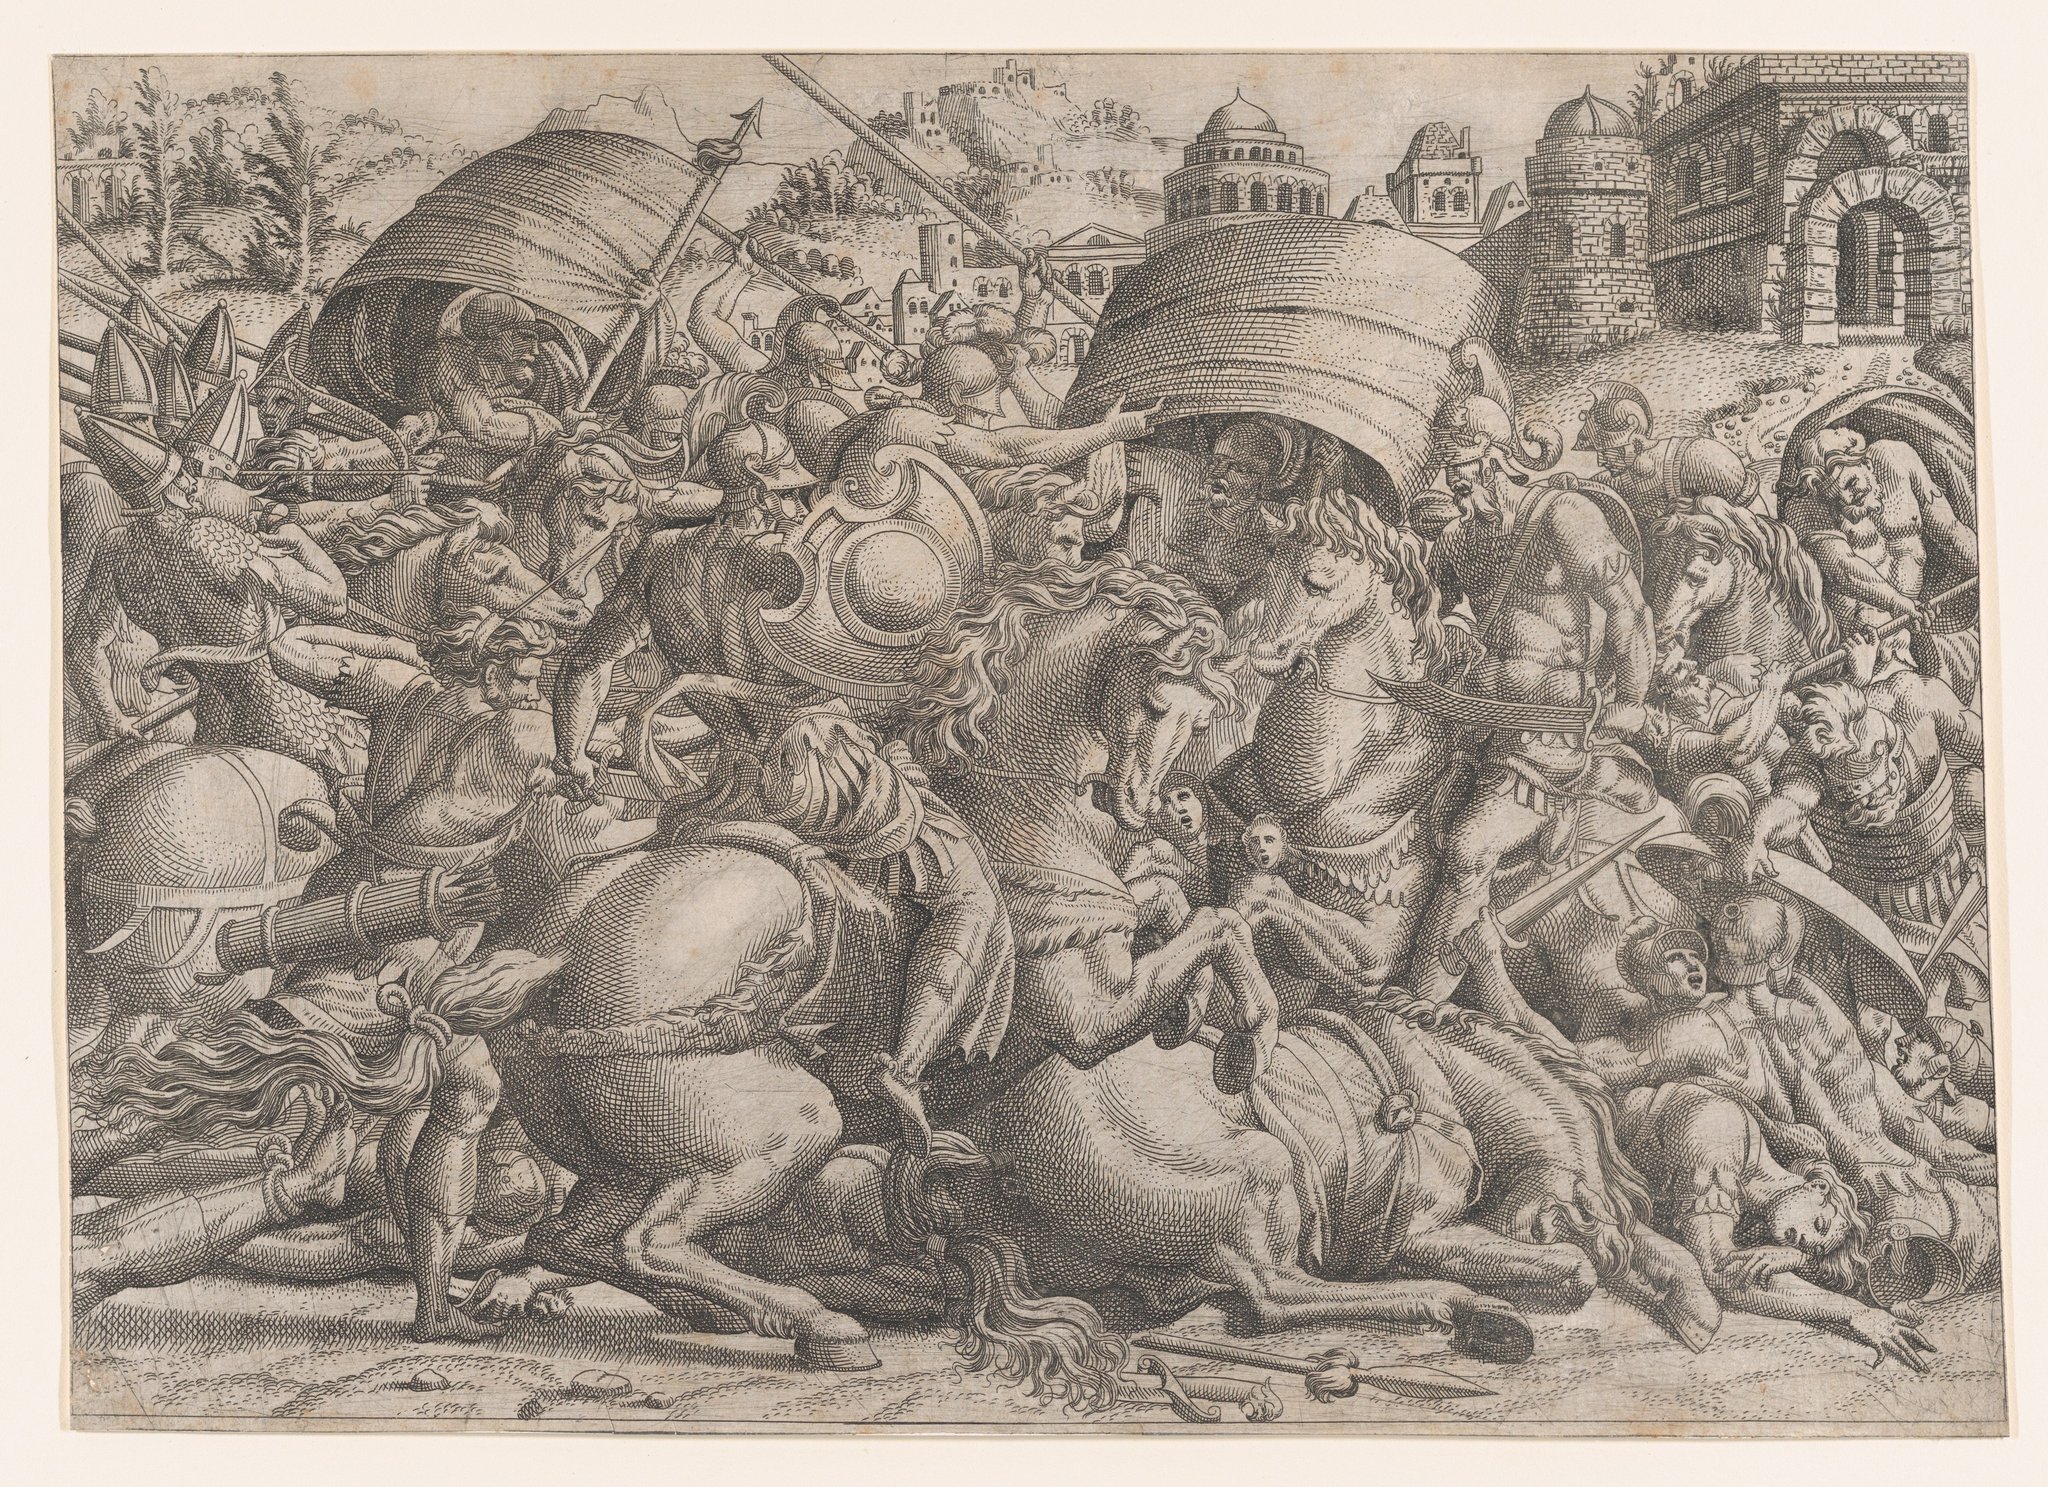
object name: print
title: Battle Before Troy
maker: jean mignon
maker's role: artist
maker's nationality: french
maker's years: 1535-1555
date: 1535-1555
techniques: etching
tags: battles,weapons,men,horses